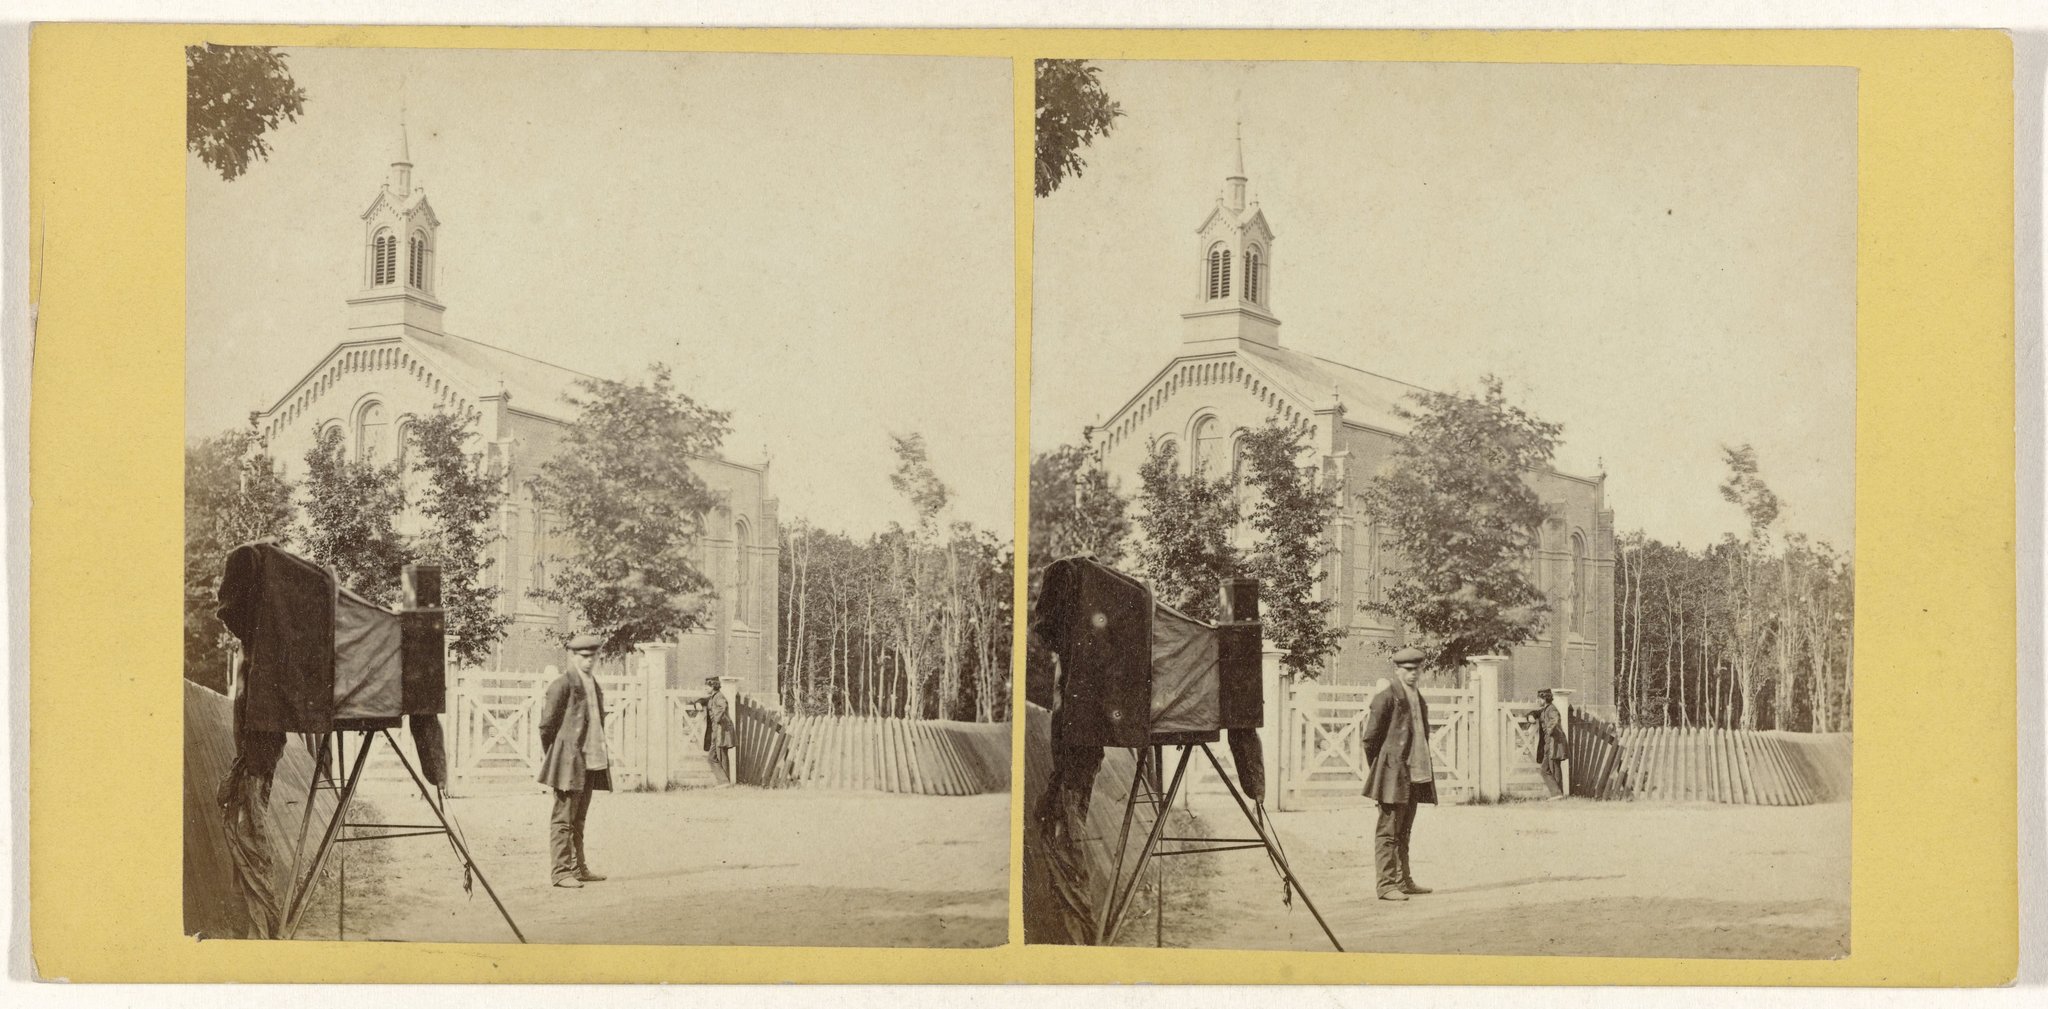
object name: stereograph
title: Kerk bij het provinciaal ziekenhuis van Bloemendaal met op de voorgrond mogelijk fotograaf Pieter Oosterhuis en zijn assistent.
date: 1860-1870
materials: cardboard, paper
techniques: albumen print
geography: amsterdam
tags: photographer at work - cc - out of doors, church (exterior)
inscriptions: address: ‘UITGAVE VAN A. JAGER, WATER 110, AMSTERDAM.’, inscription: ‘Coll RBK’